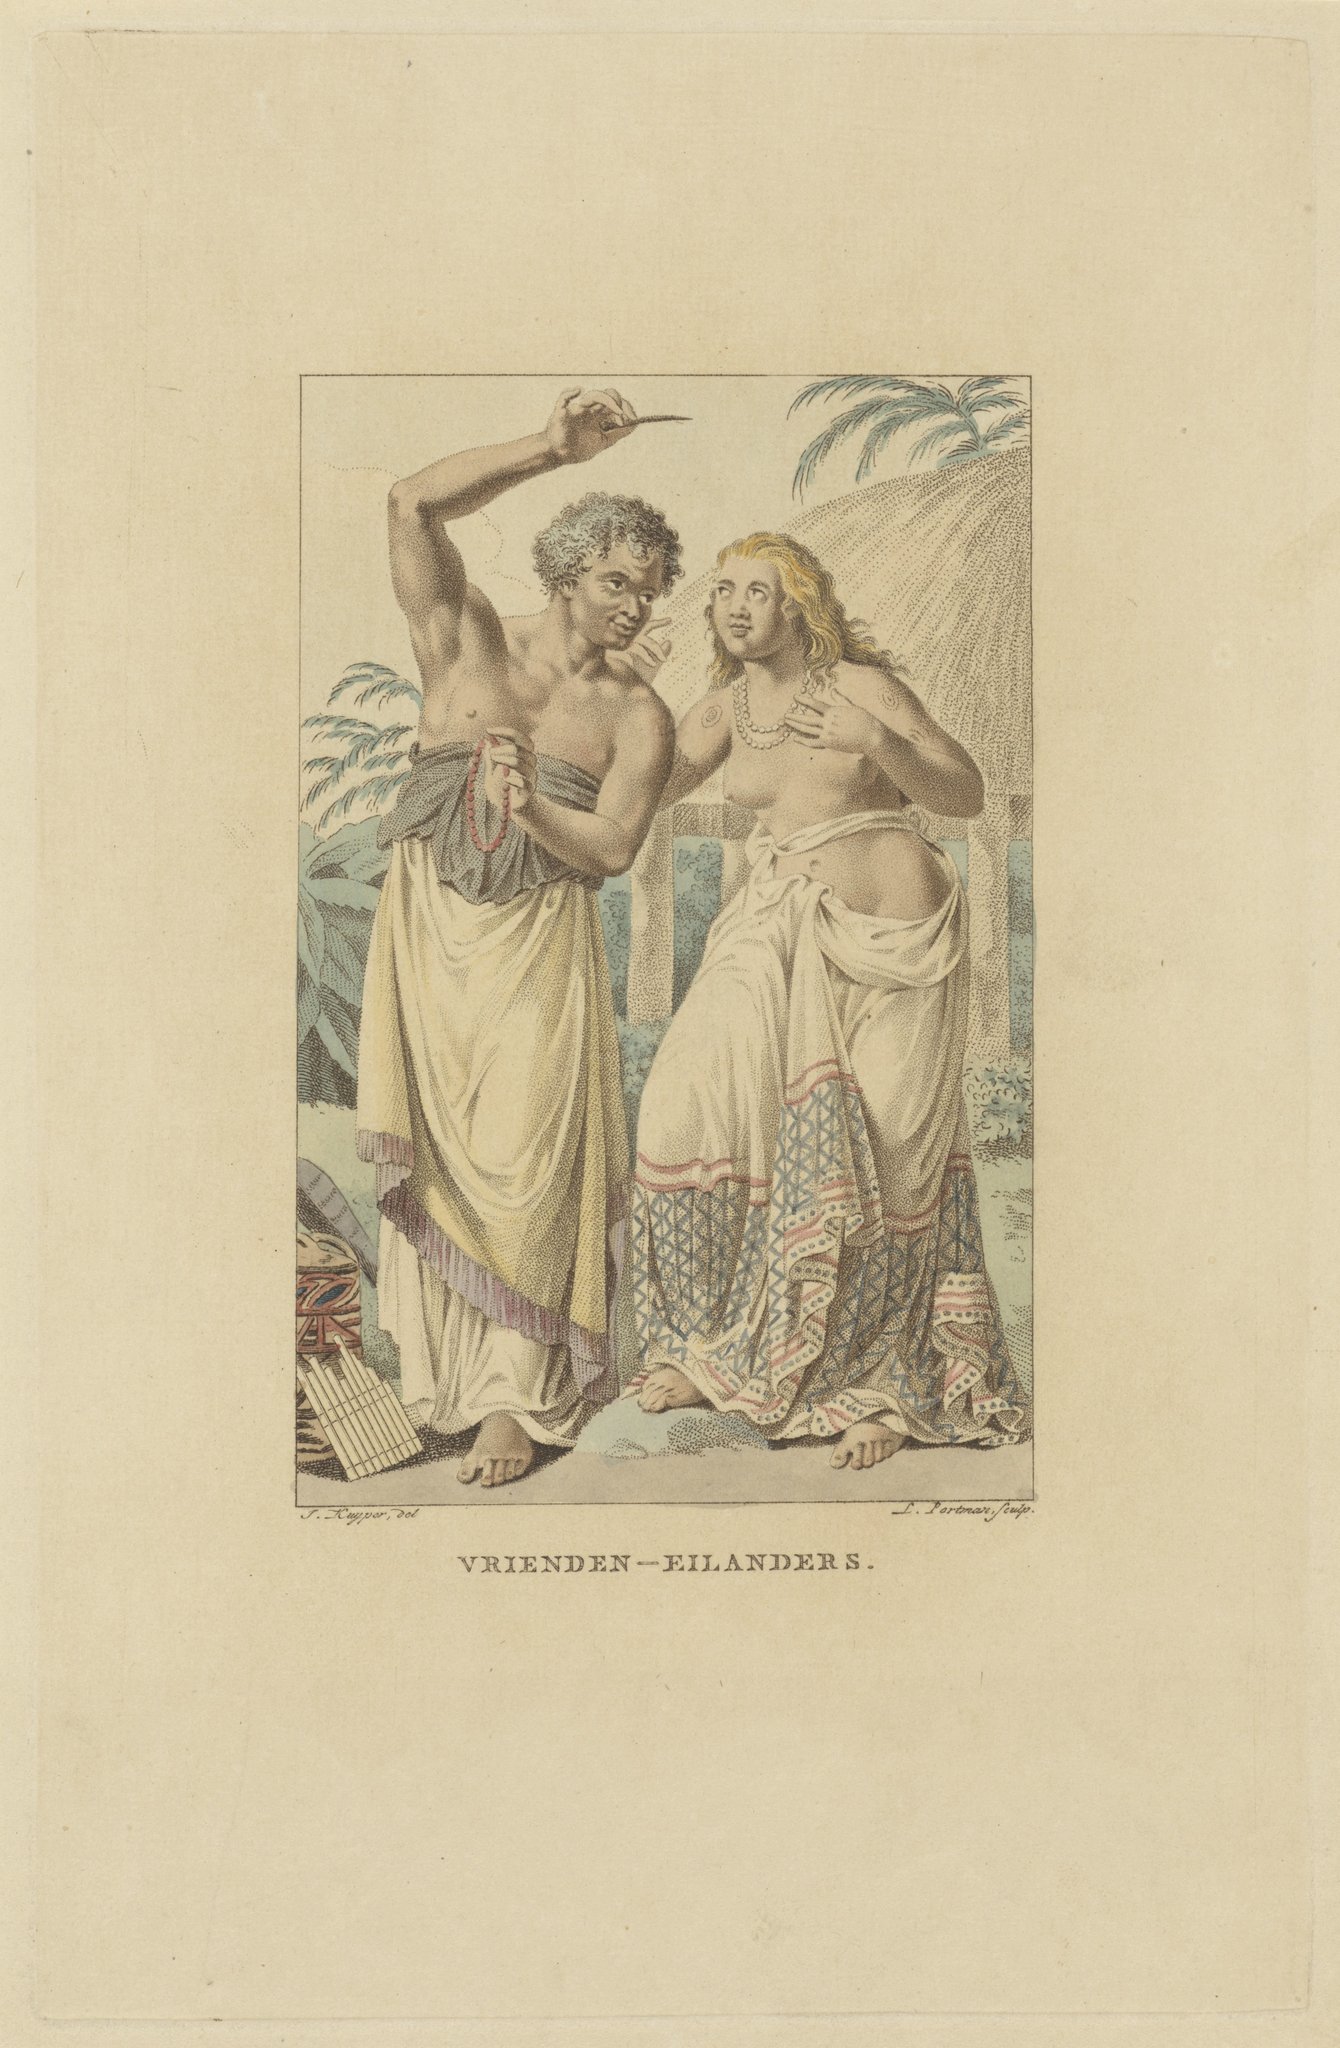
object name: print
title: Bewoners van de Vrienden Eilanden (Tonga Archipel)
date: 1803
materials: paper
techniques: etching, hand coloring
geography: amsterdam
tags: tools, aids, implements ~ crafts and industries: nail, human races; peoples; nationalities (+ costume)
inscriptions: collector's mark: Lugt 2228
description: Een man heeft een spijker ontvangen van zijn vrouw die hij, volgens het plaatselijk gebruikt, boven zijn hoofd houdt. Hij geeft aan zijn vrouw een ketting. Op de voorgrond een fluit. Ze dragen traditionele kleding.